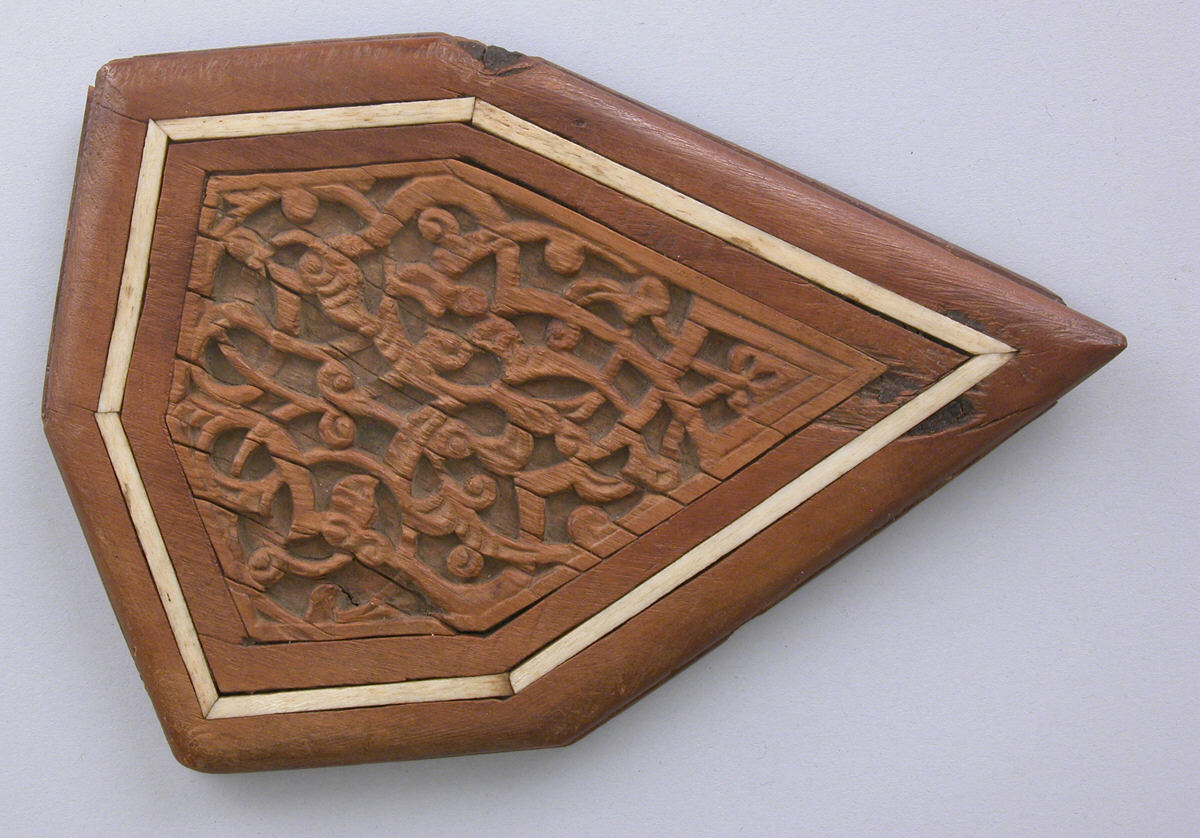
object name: panel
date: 1201-1400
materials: bone, ivory, wood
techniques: carving, inlay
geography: egypt